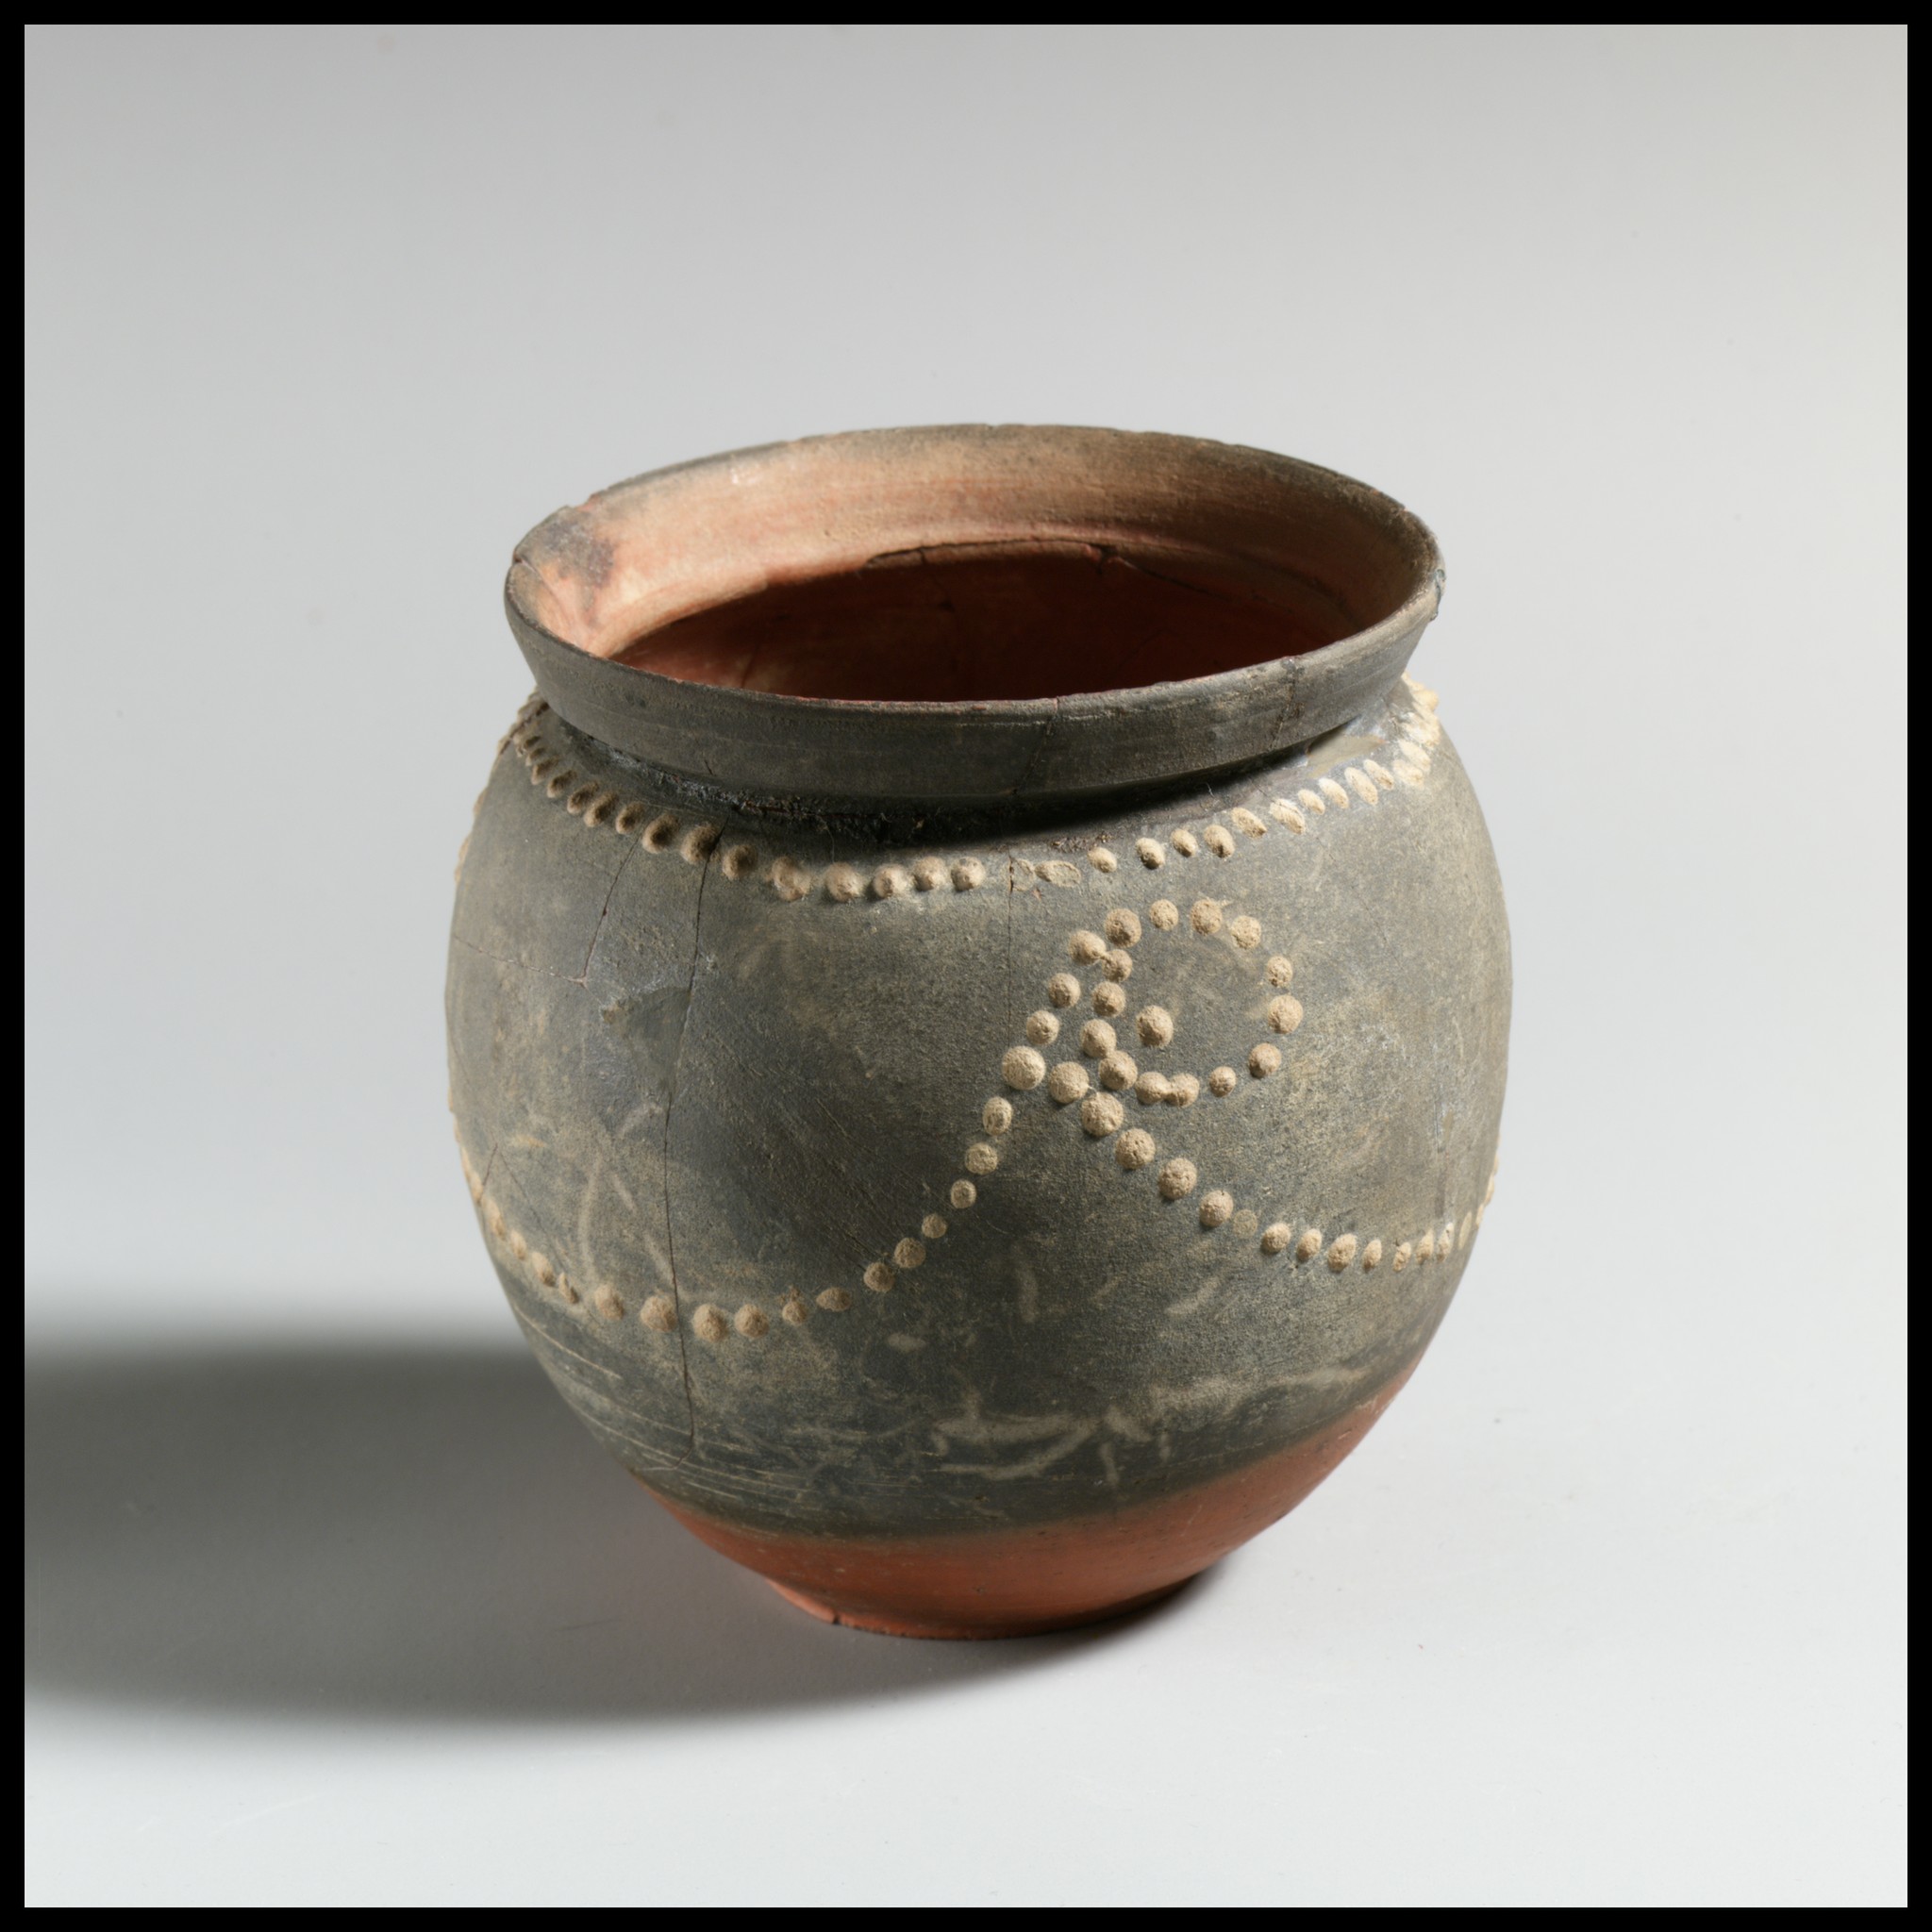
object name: vase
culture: roman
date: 670 BCE-330 CE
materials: terracotta